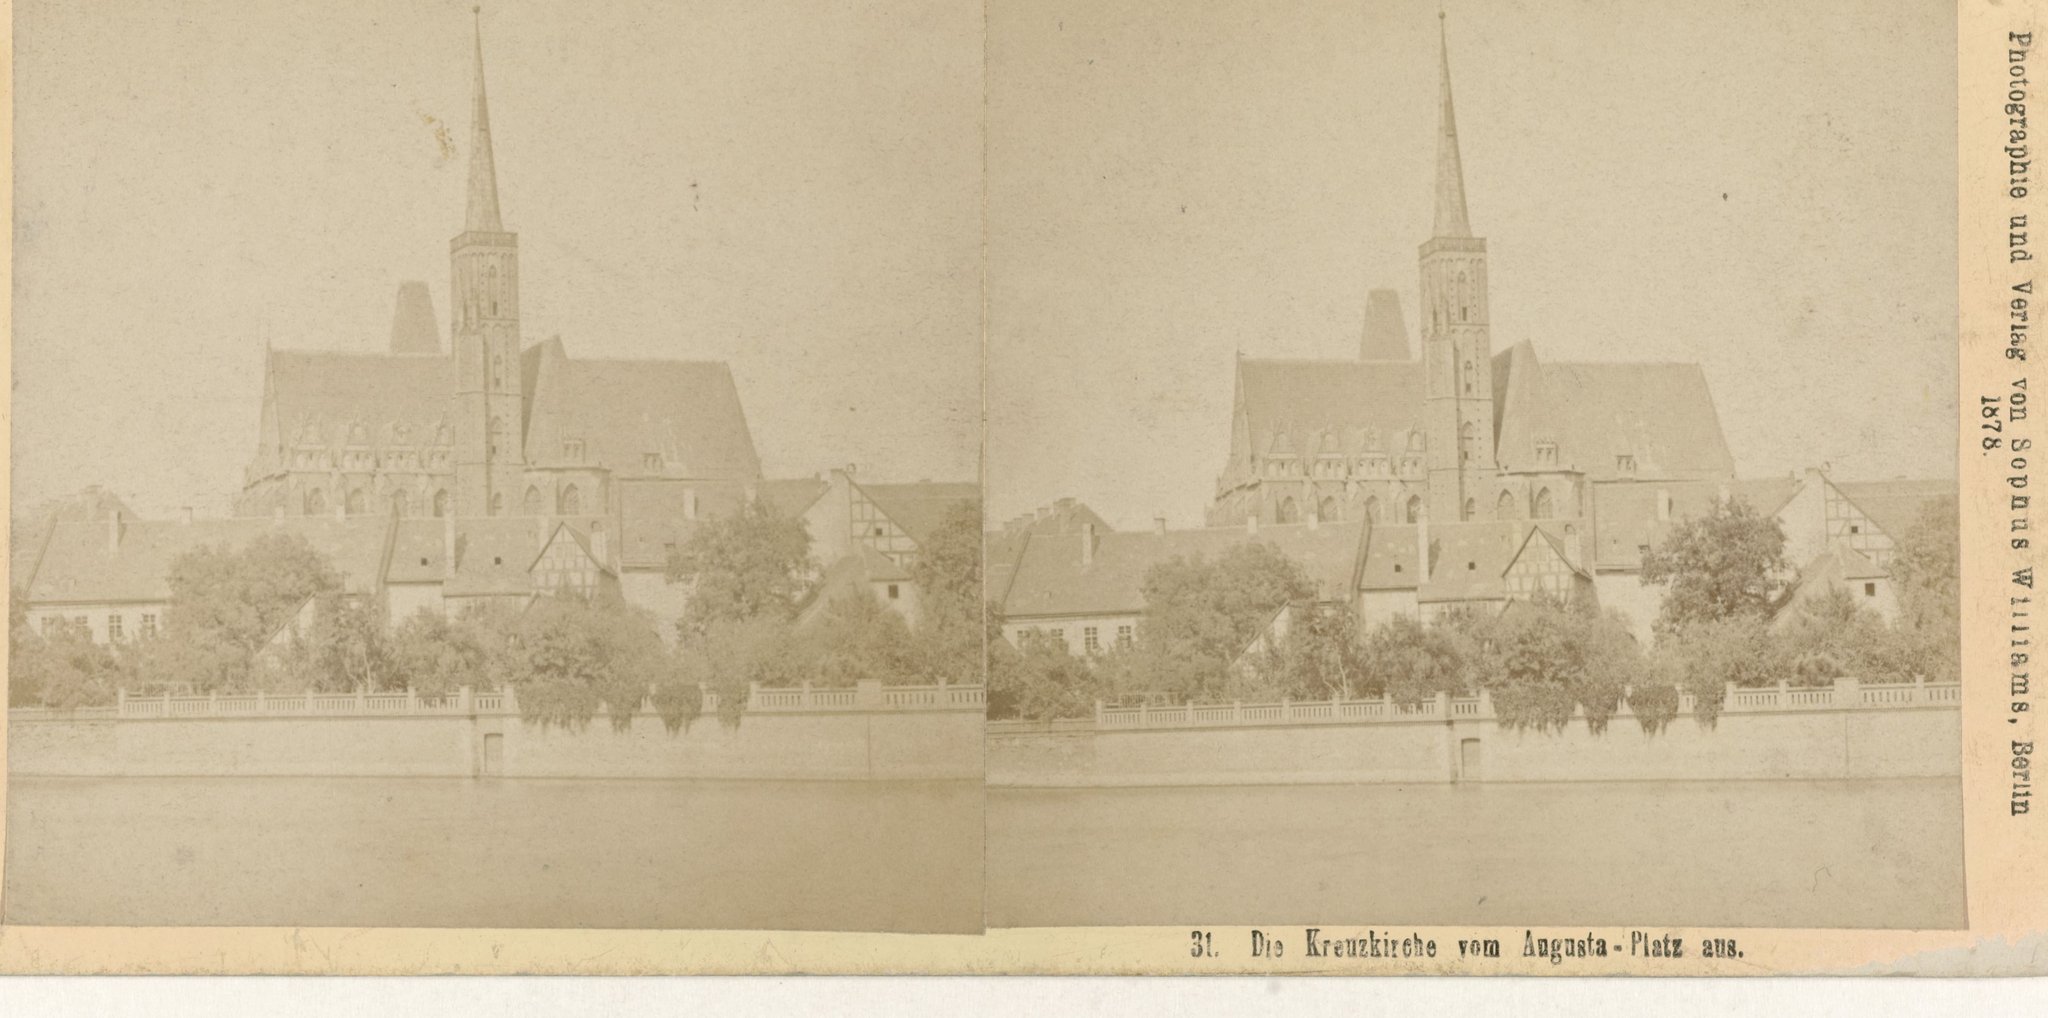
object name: stereograph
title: Exterieur van de Kreuzkirche in Wroclaw, gezien vanaf Augusta-Platz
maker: sophus williams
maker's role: publisher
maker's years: 1835-1900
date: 1878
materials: cardboard, paper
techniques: albumen print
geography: wroclaw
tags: church (exterior)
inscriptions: number: ‘31.’